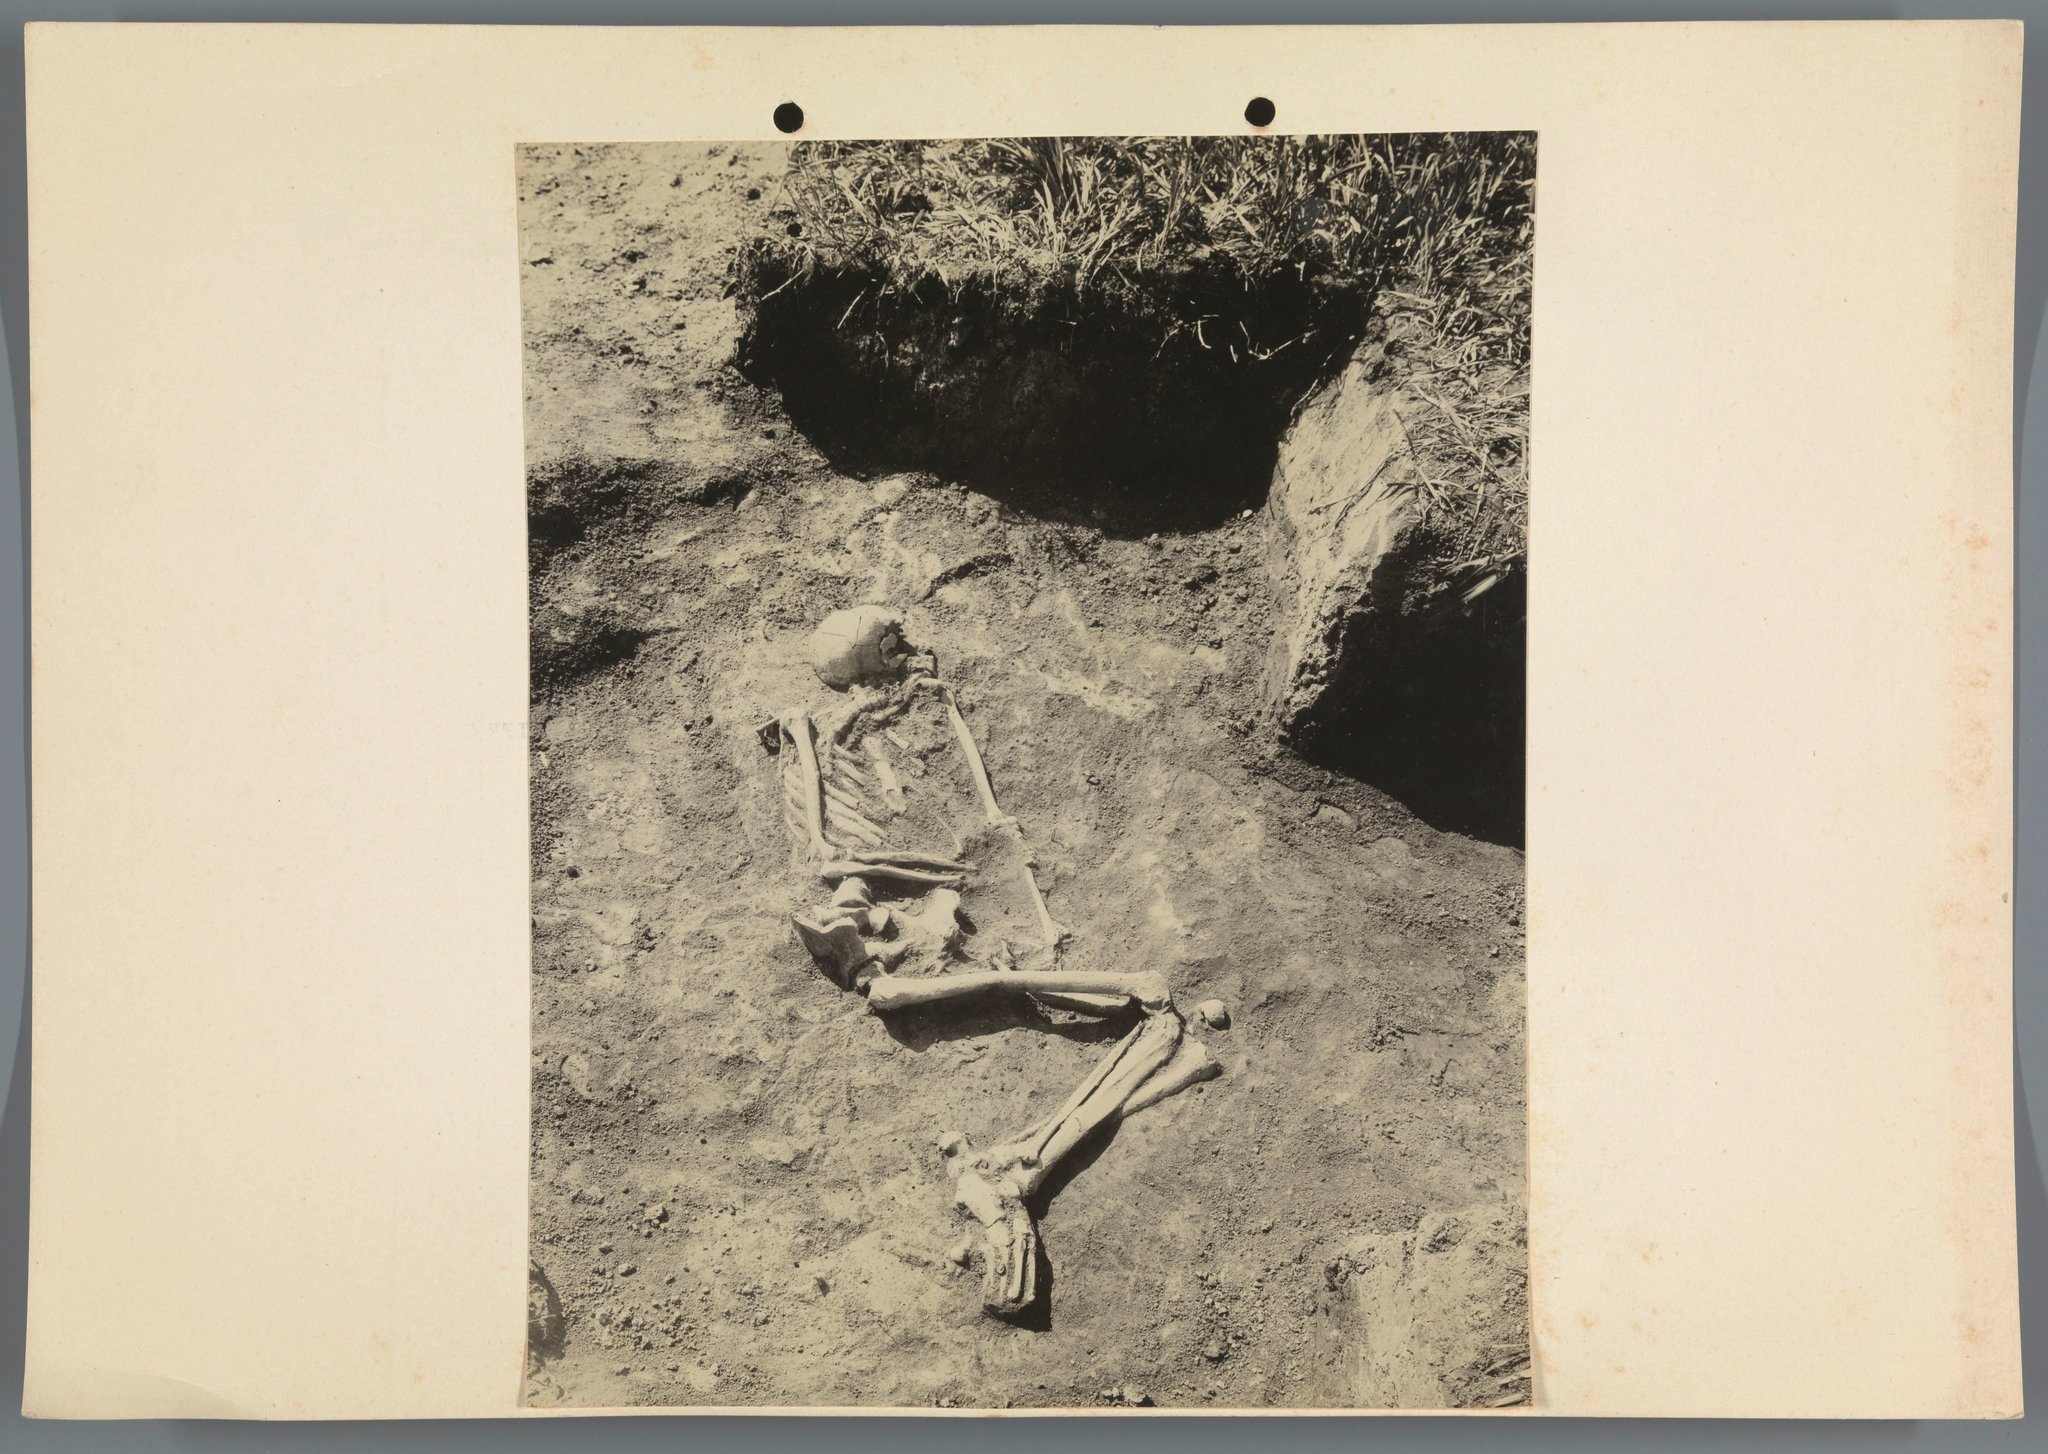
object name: photograph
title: Grafveld aan de Theys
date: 1905-1928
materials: paper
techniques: gelatin silver print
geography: hungary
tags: (human) skeleton, excavation ~ archaeology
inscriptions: inscription: ‘Hollandsche Archaeologische Expeditie/ Grafveld aan de Theys/ hurkengraf ±2500 v.C. door mij zelf blootgelegd./ Mei 1928/ Leider Dr. A.E. van Giffen’